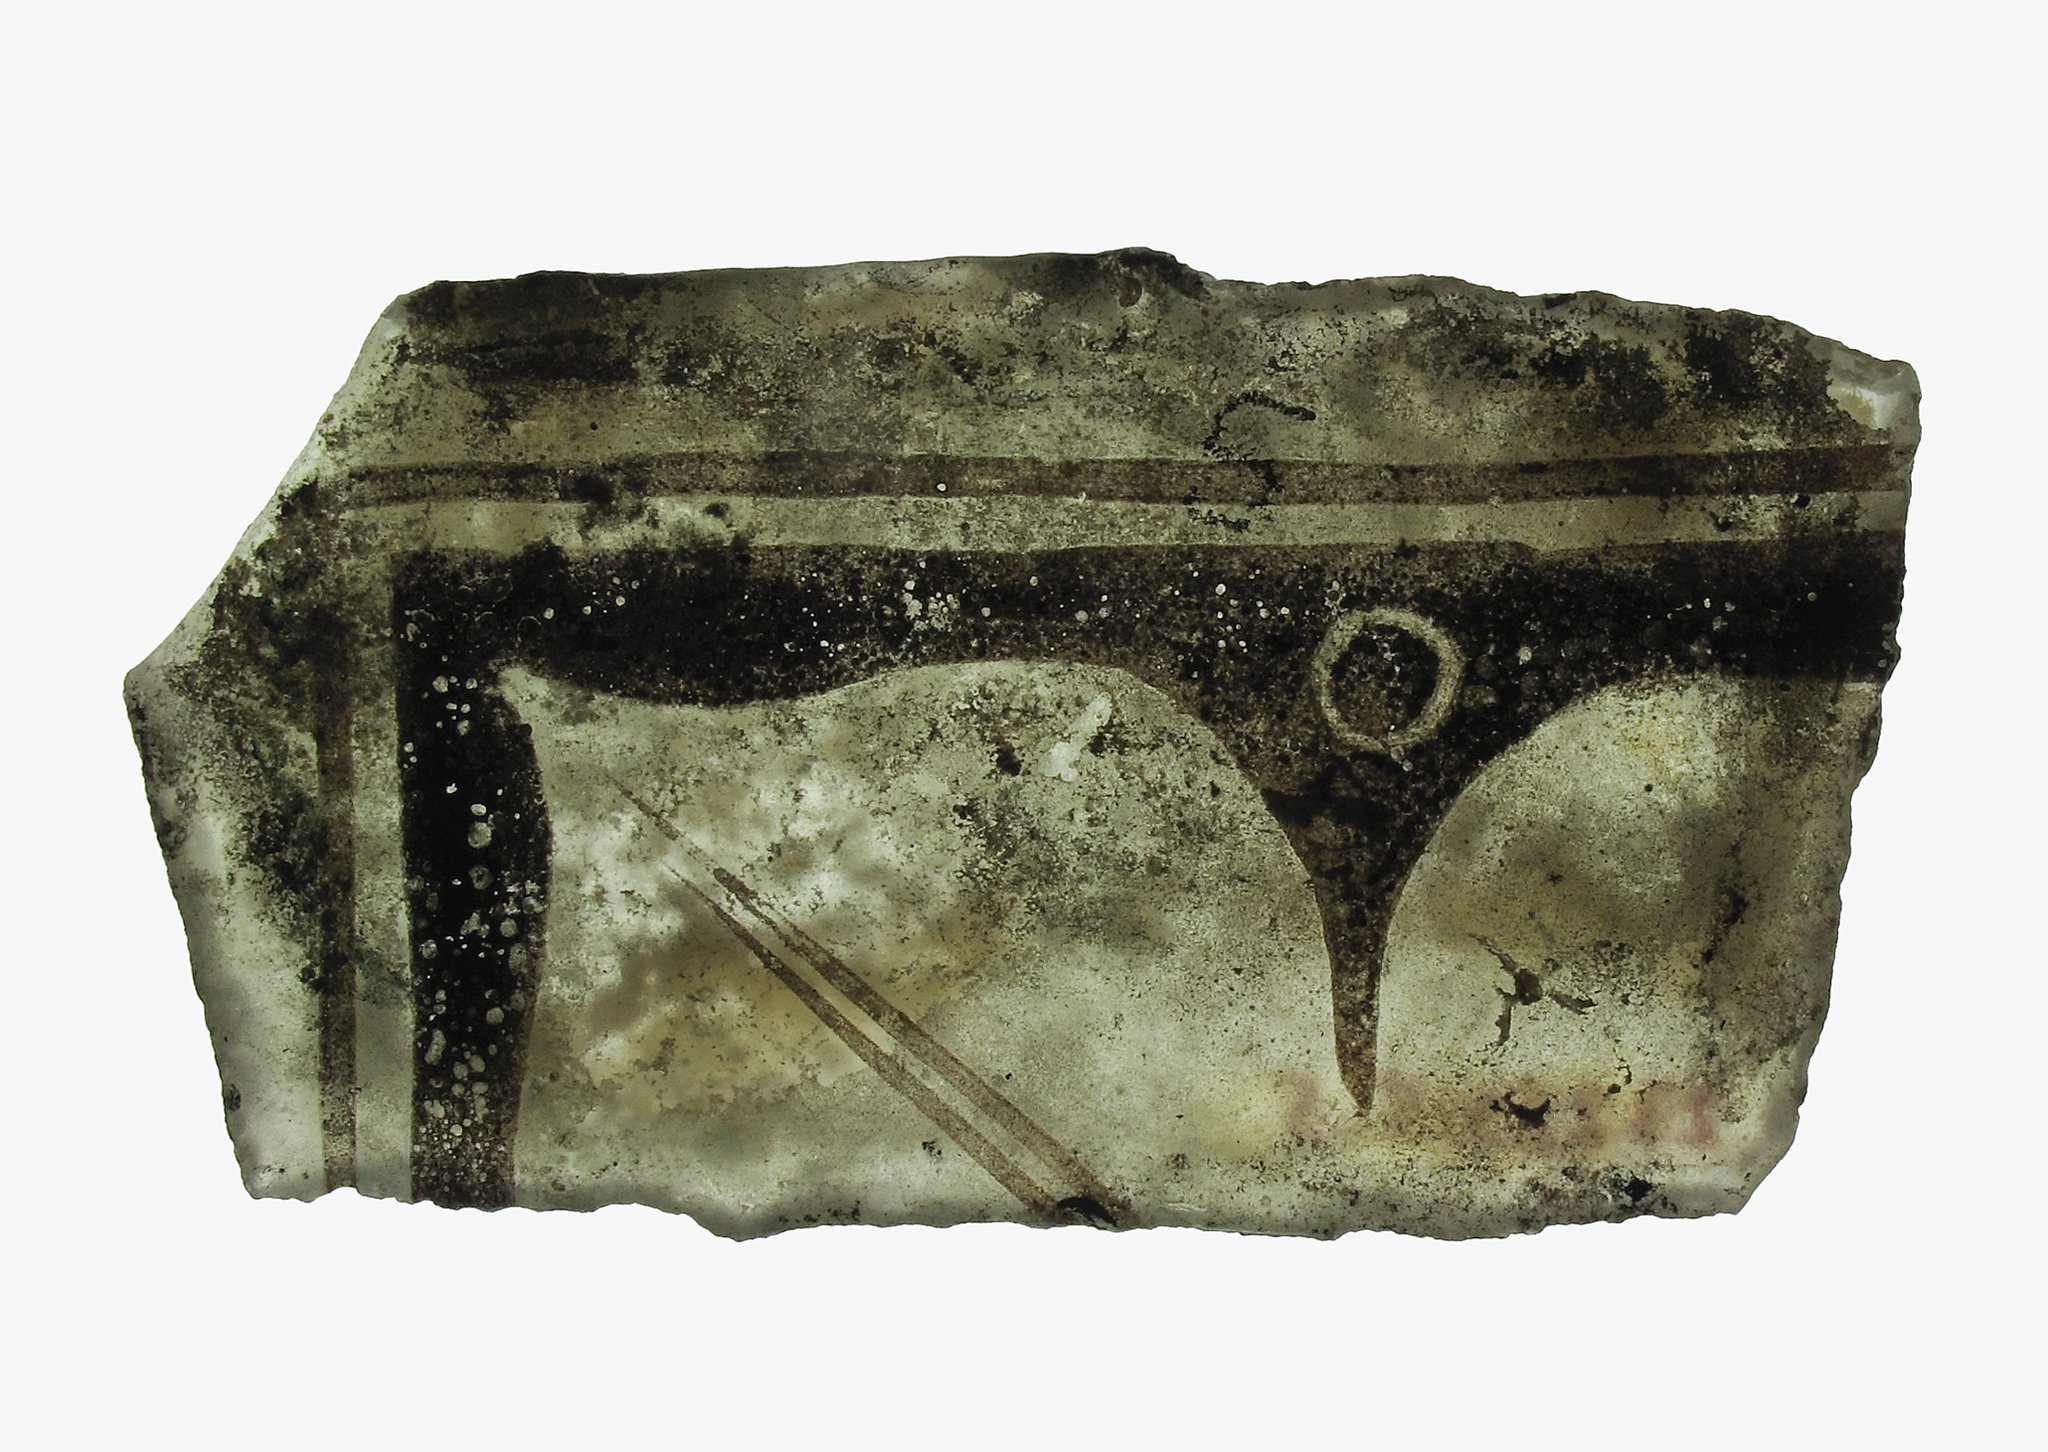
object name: fragment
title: Glass Fragment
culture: french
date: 1201-1300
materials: glass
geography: france